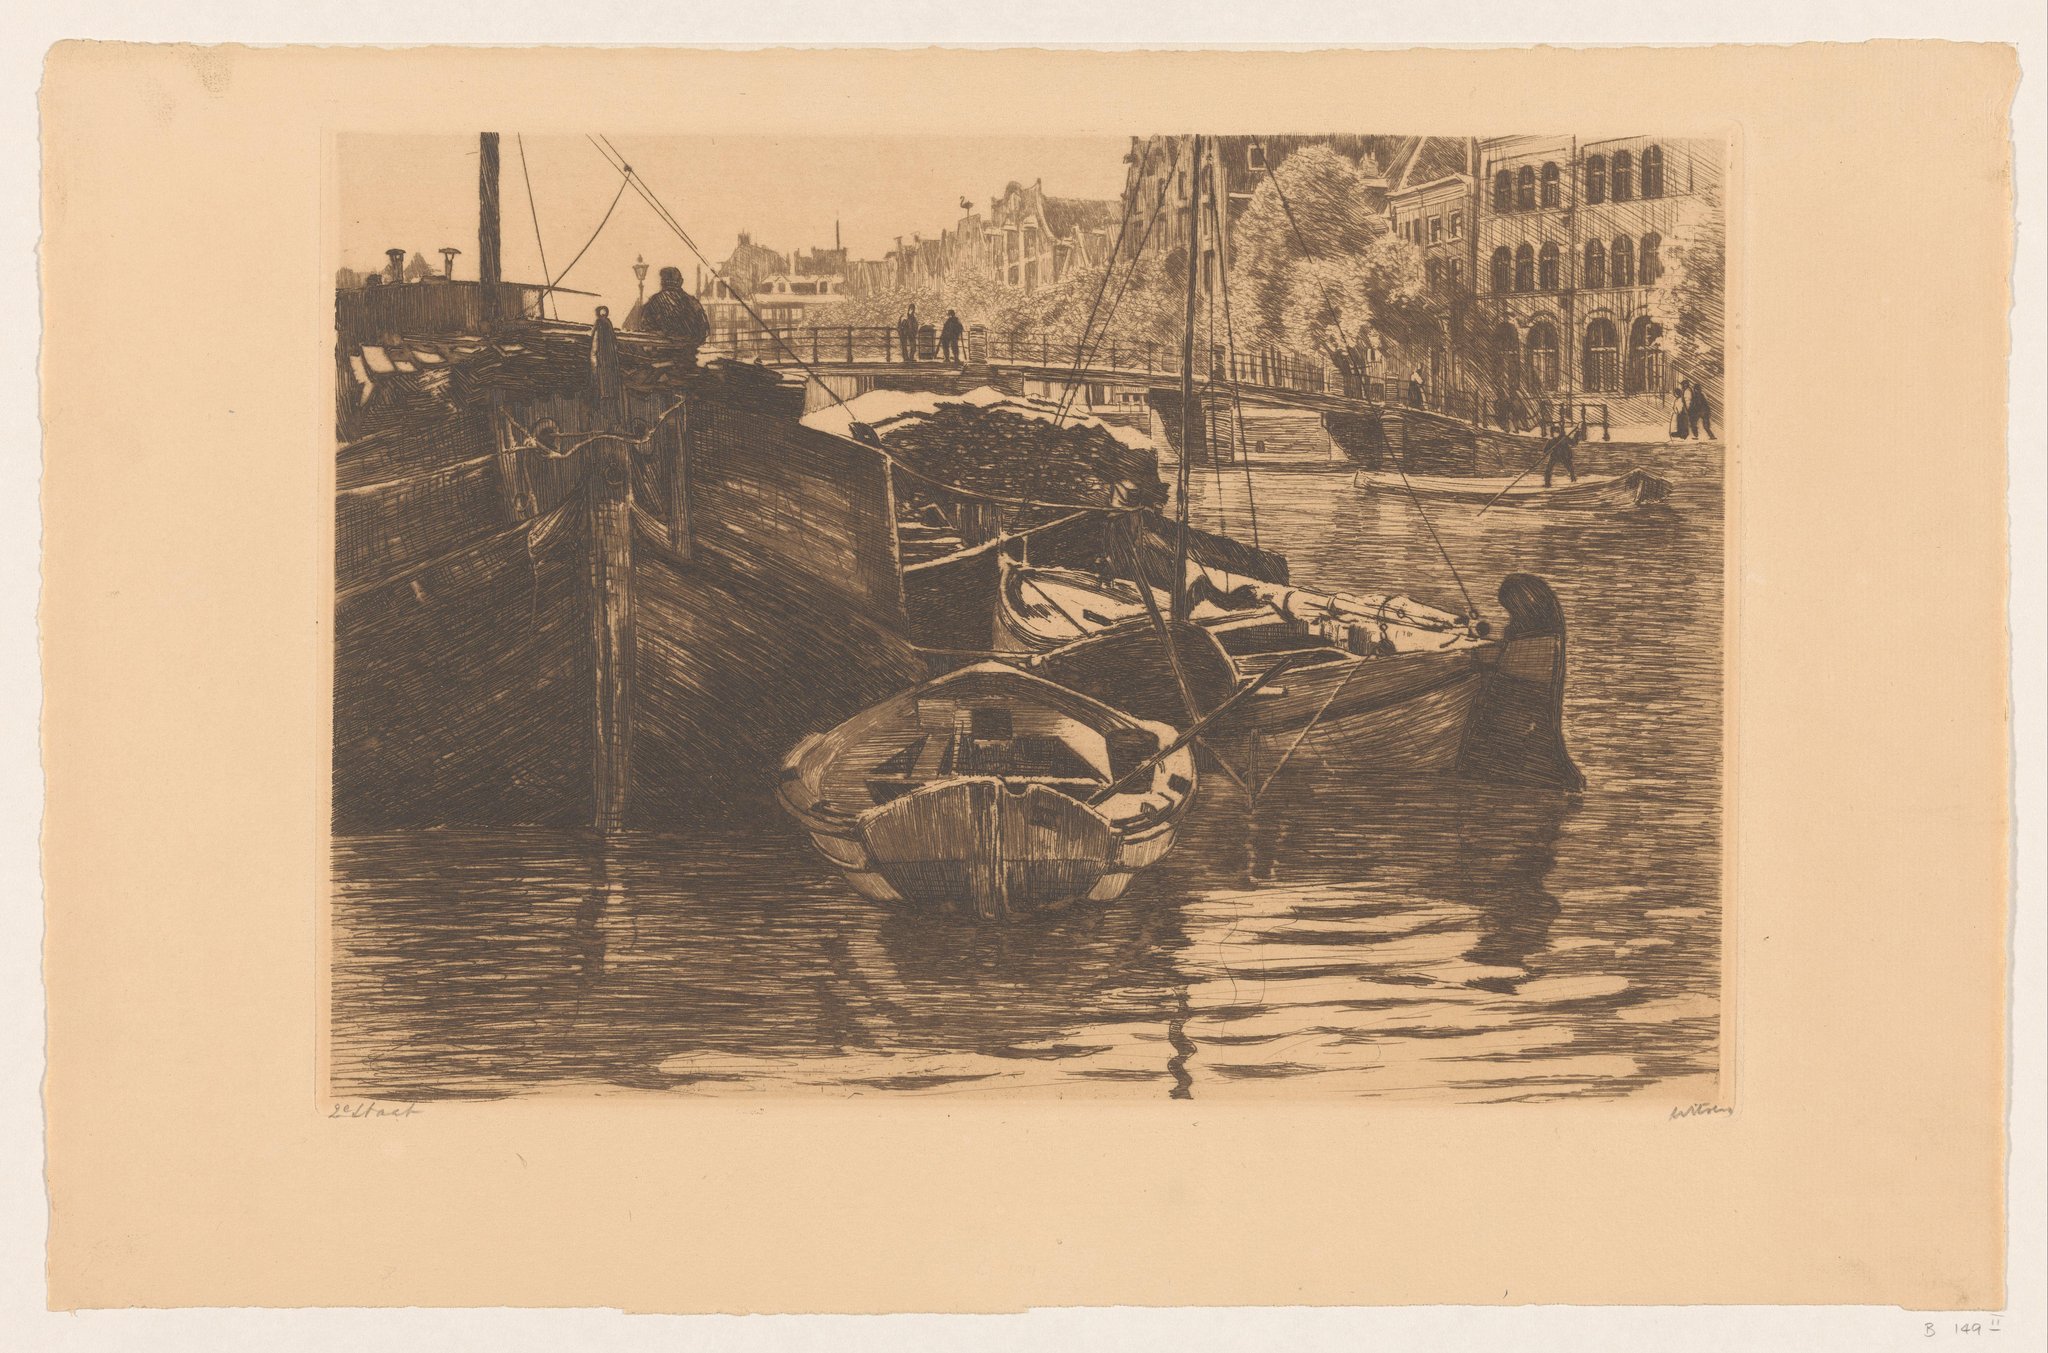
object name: print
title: Turfschepen in de Oude Schans in Amsterdam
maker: willem witsen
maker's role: draughtsman, painter, print maker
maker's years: 1860-1923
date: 1911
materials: paper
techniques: etching, intaglio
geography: amsterdam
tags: urban housing, canals, waters (in city), boat propelled by man or animal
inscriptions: collector's mark: Lugt 2228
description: Gezicht op turfschepen in de Oude Schans bij de Keizersbrug. Op de achtergrond de huizen langs de Oude Schans en de Houtkopersburgwal.